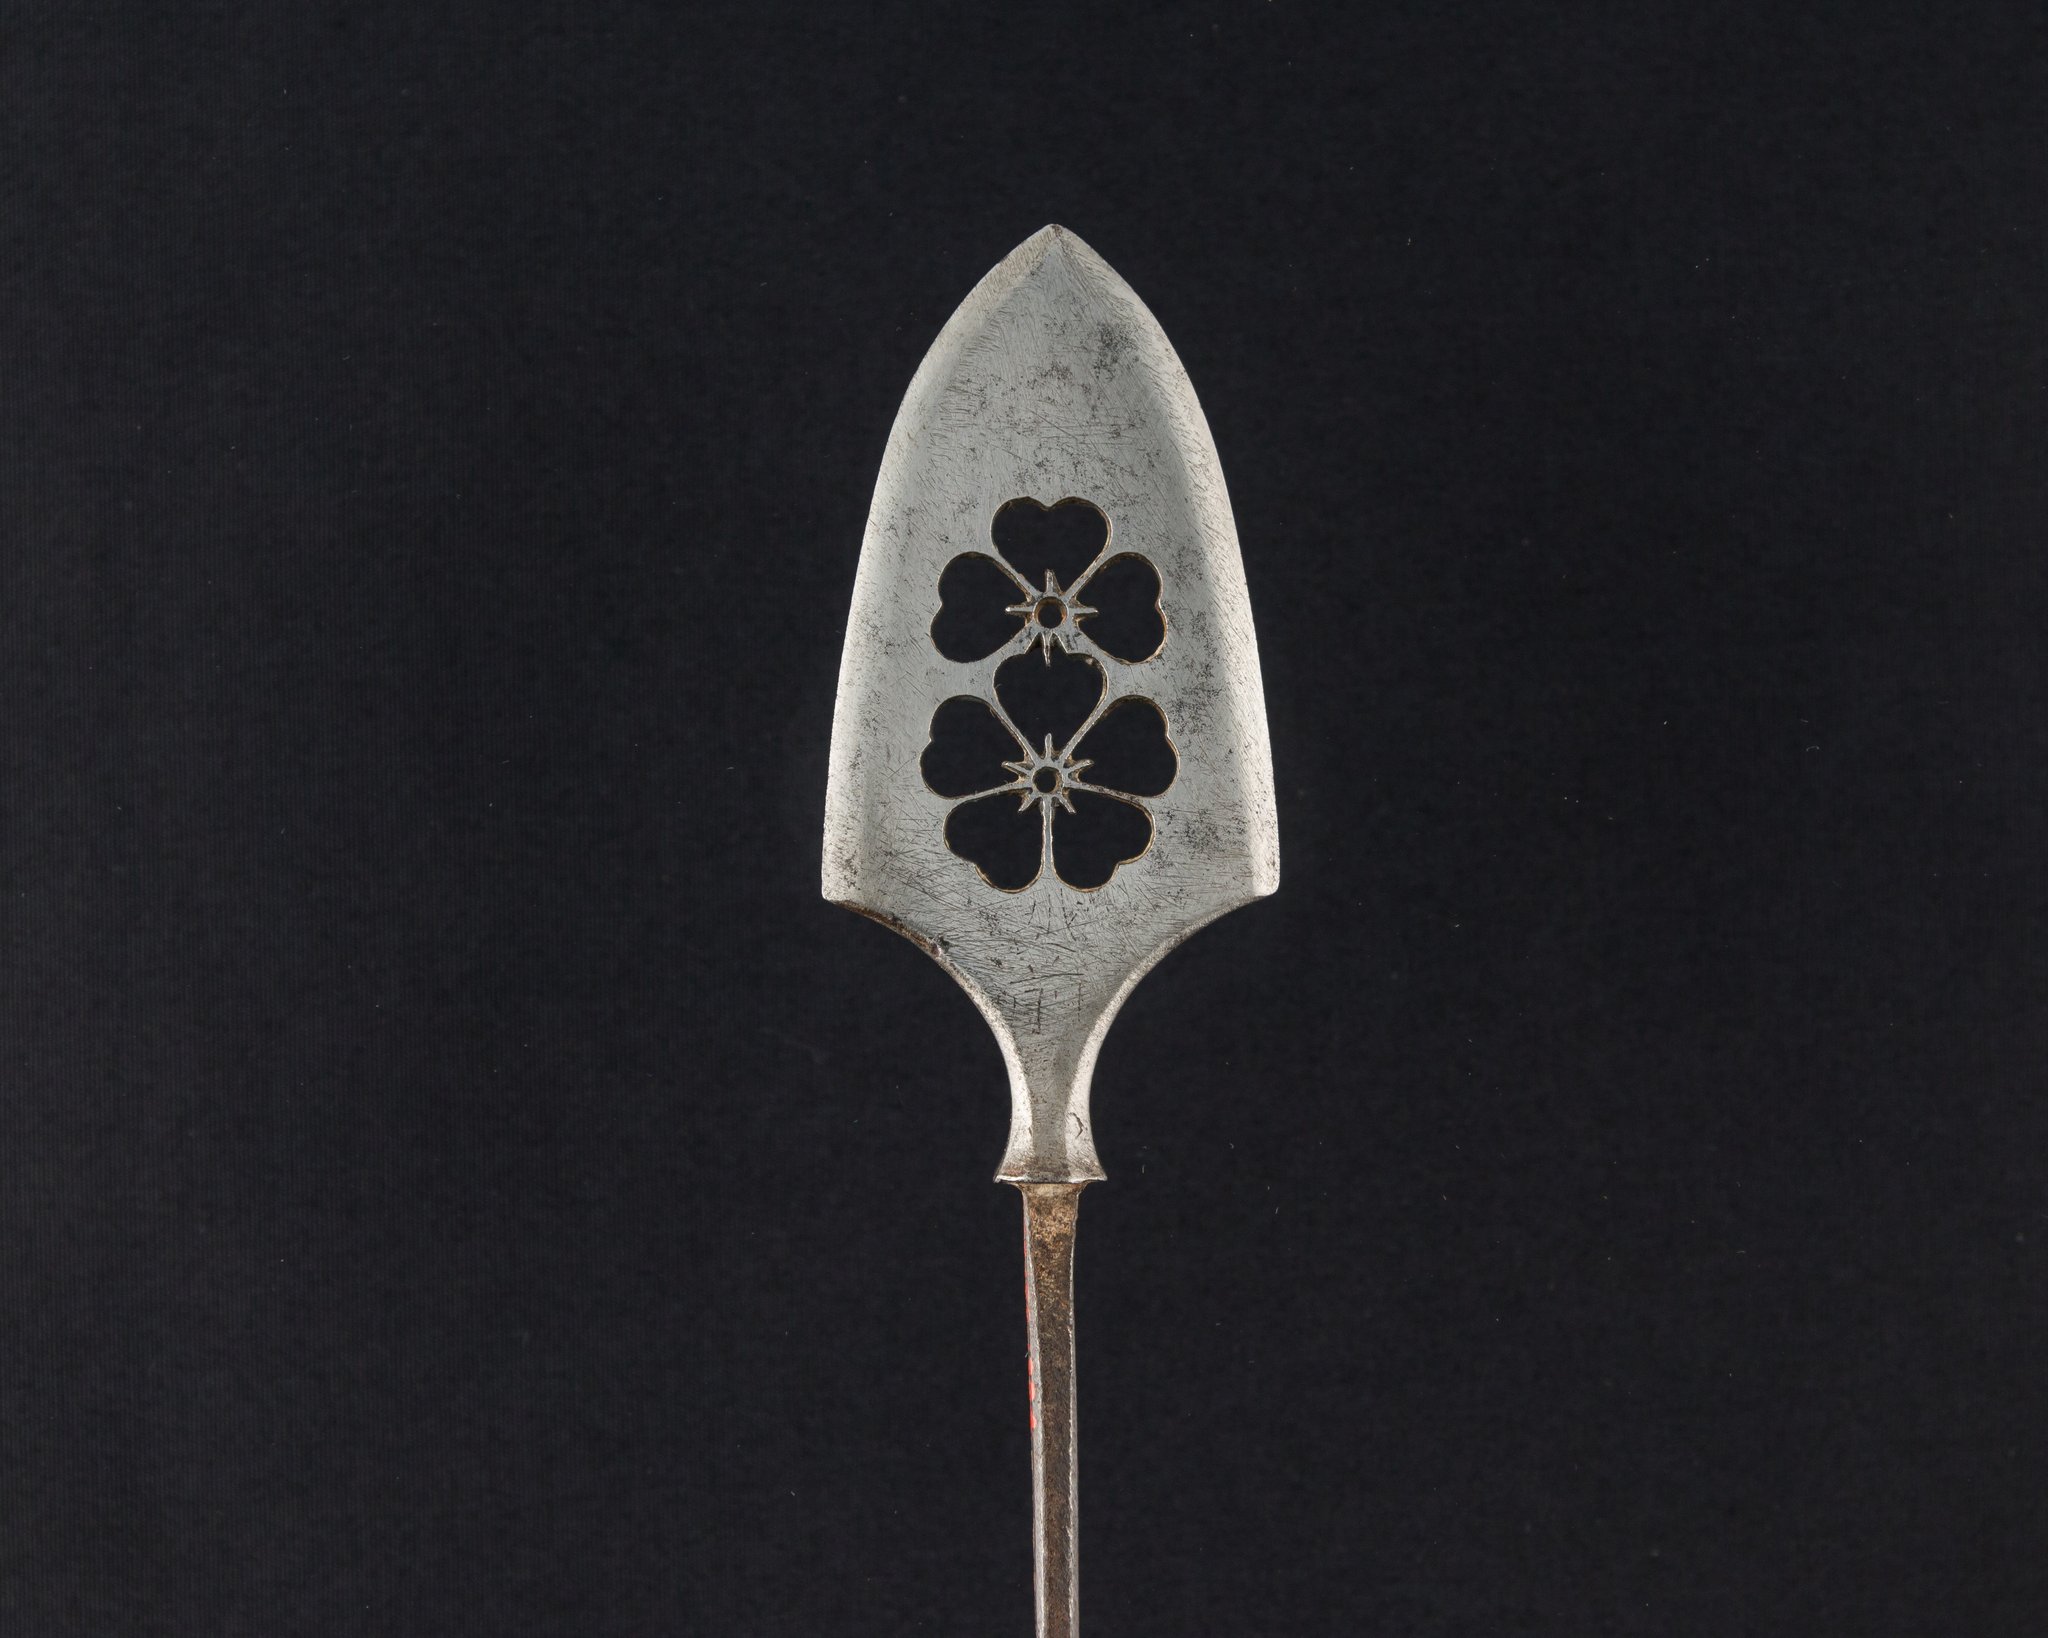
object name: arrowhead i yanone i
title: Arrowhead (Yanone)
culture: japanese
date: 1615-1868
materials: steel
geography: japan